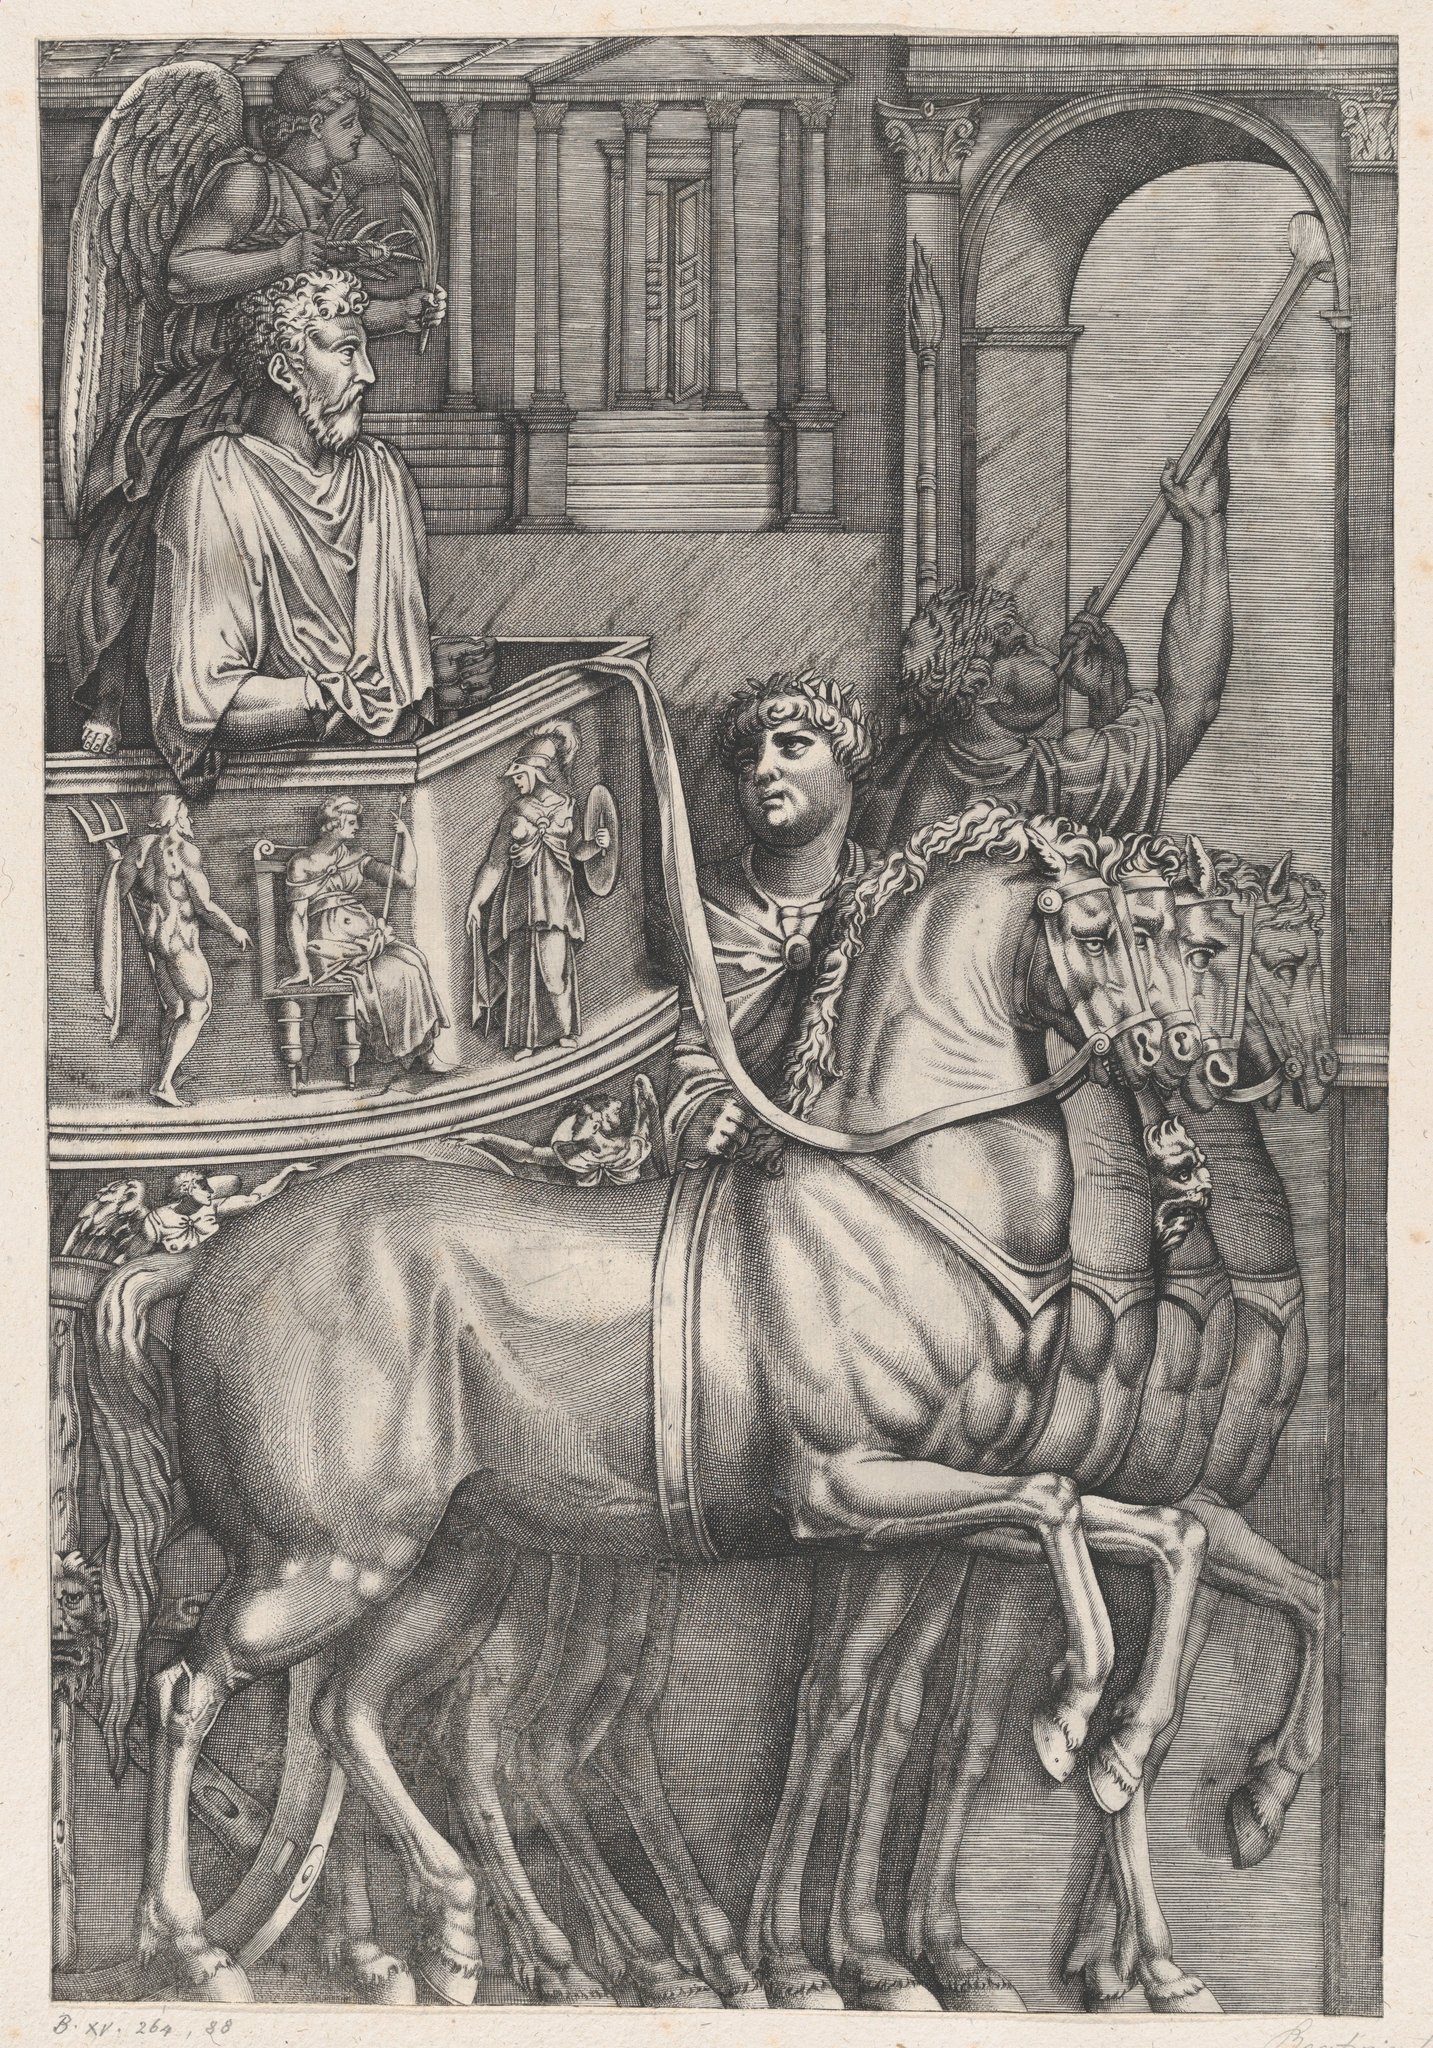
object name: print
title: The Triumph of Marcus Aurelius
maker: nicolas beatrizet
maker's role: artist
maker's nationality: french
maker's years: 1515-1566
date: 1550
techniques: engraving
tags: musical instruments,men,horses,angels